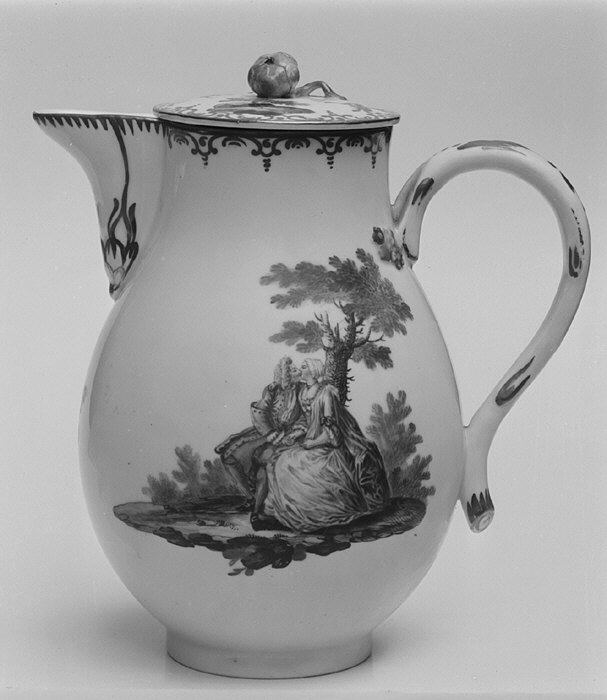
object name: milk pot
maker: ansbach pottery and porcelain manufactory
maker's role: manufactory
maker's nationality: german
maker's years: 1758-1860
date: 1776-1780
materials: hard paste porcelain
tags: lovers,trees